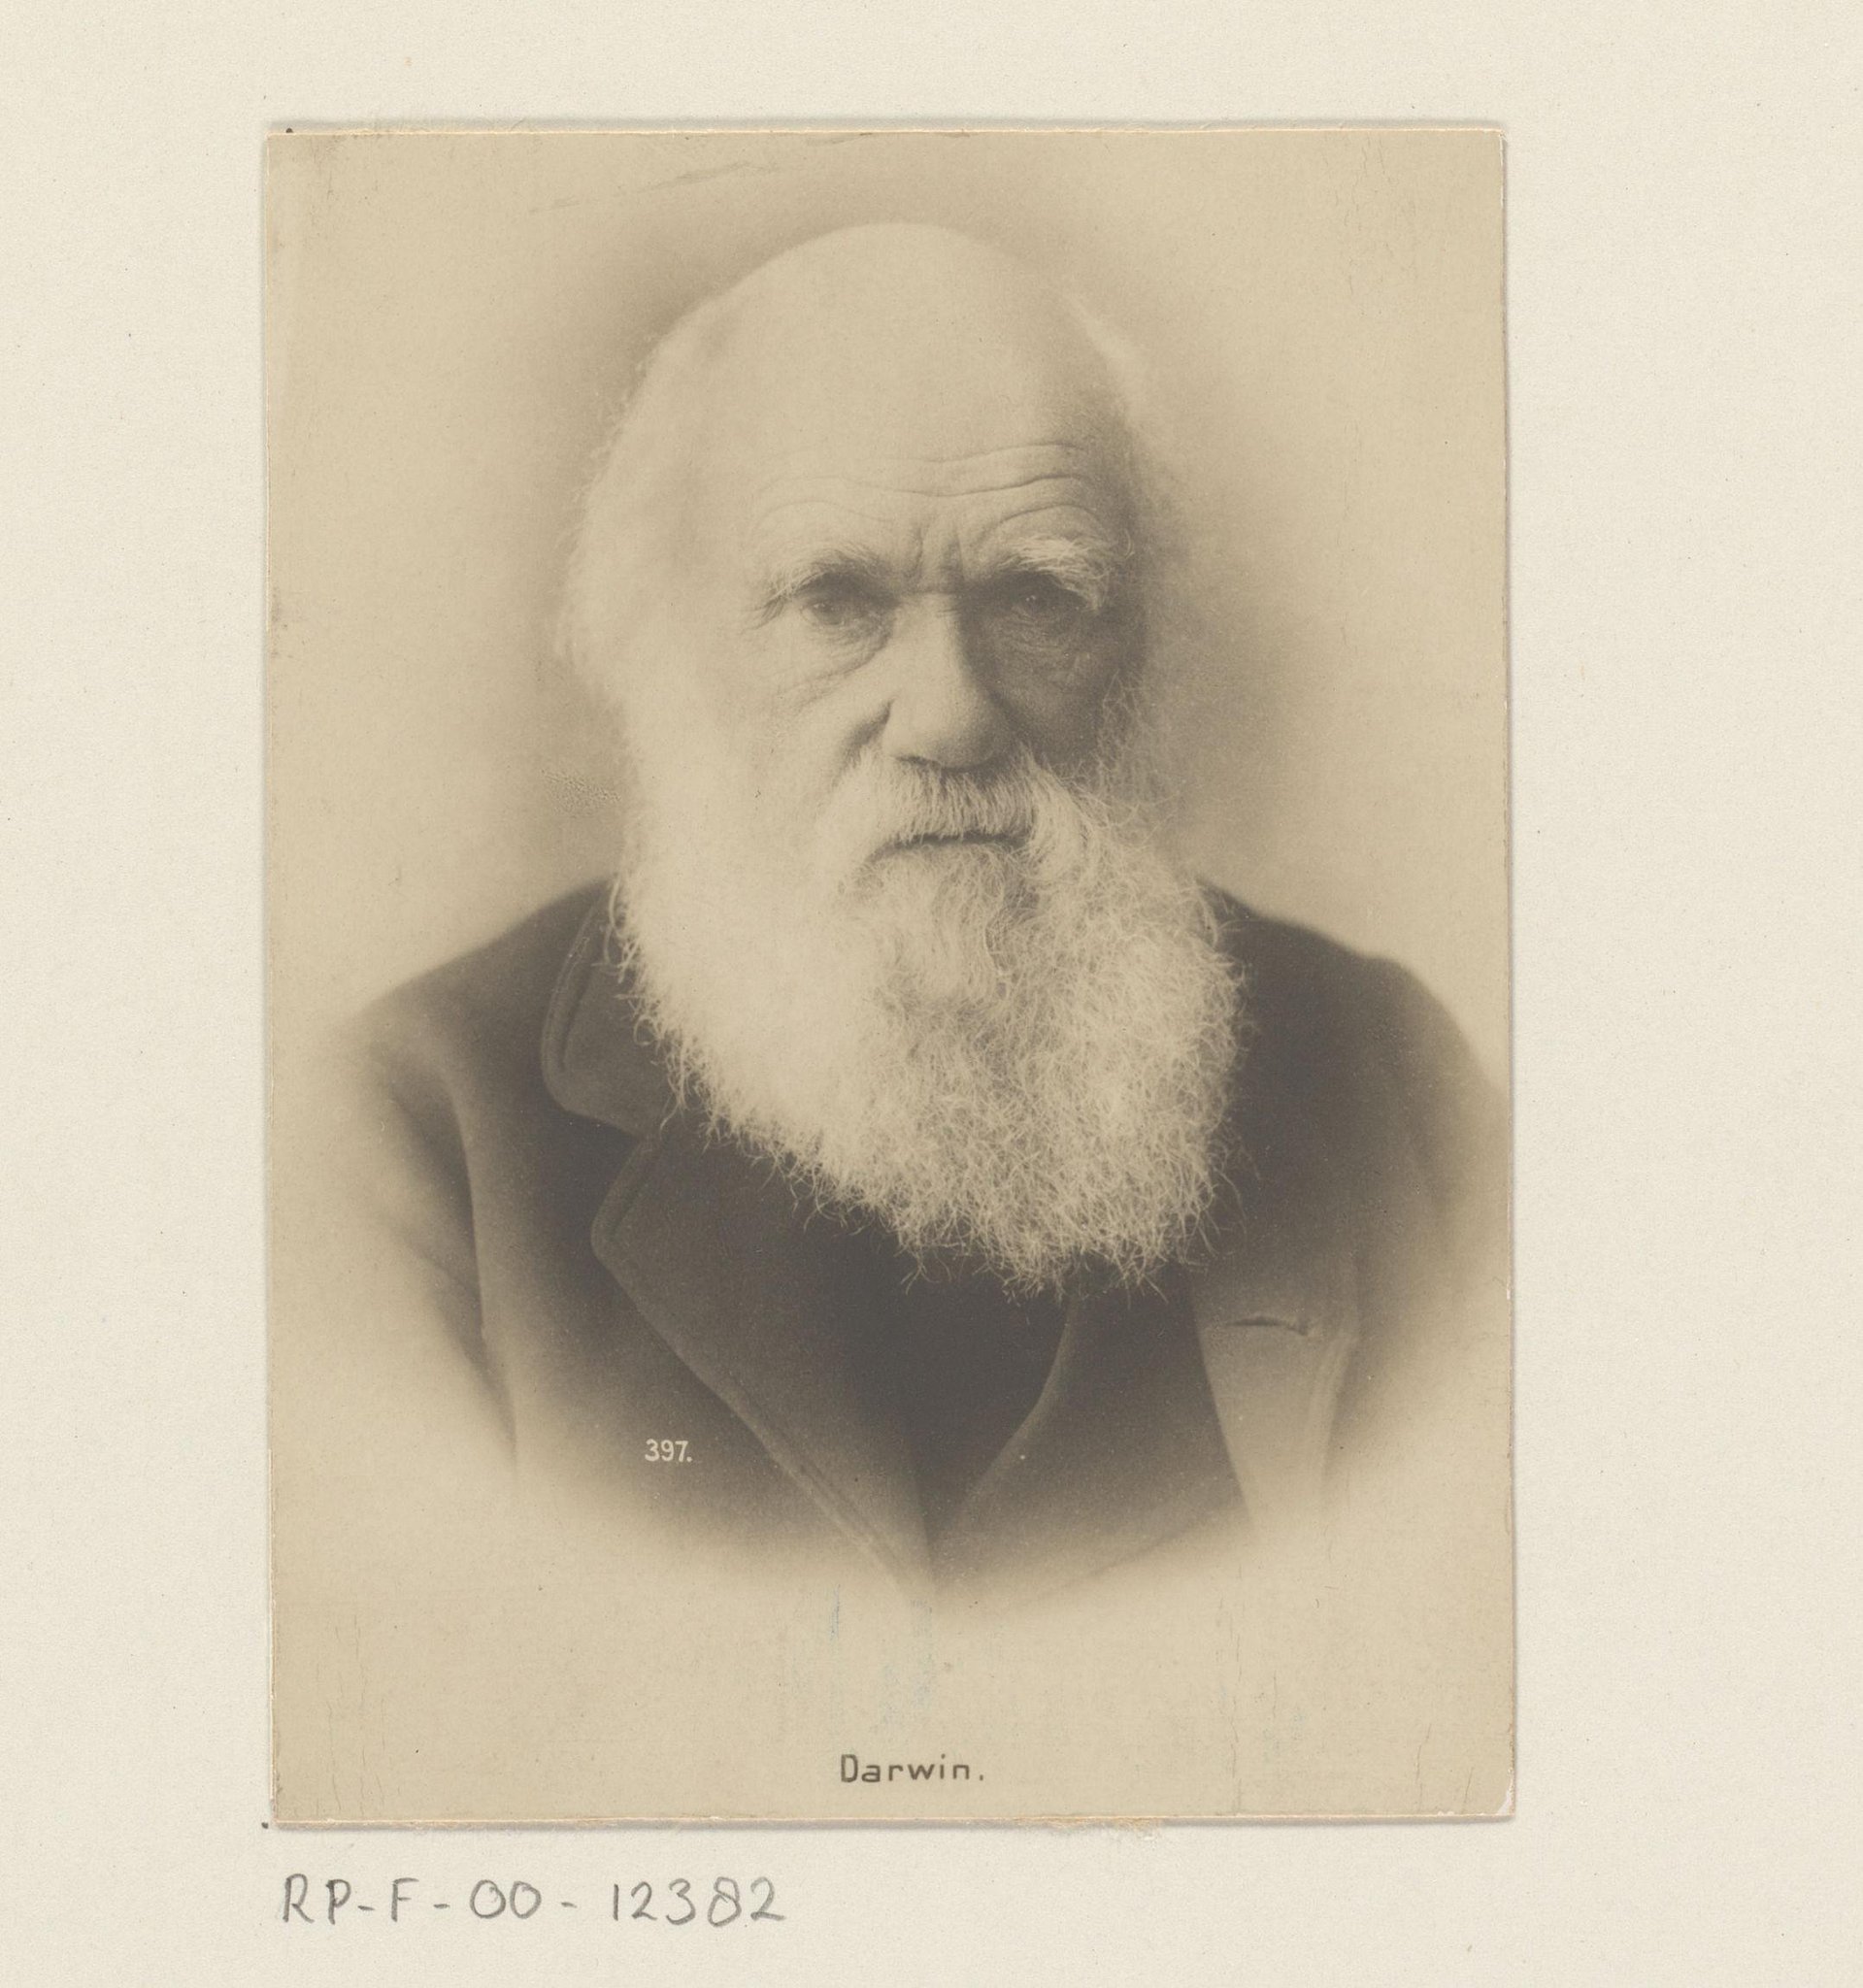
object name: ansichtkaart, prentbriefkaart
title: Darwin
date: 1874-1900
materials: paper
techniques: gelatin silver print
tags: charles darwin, historical persons, picture, painting